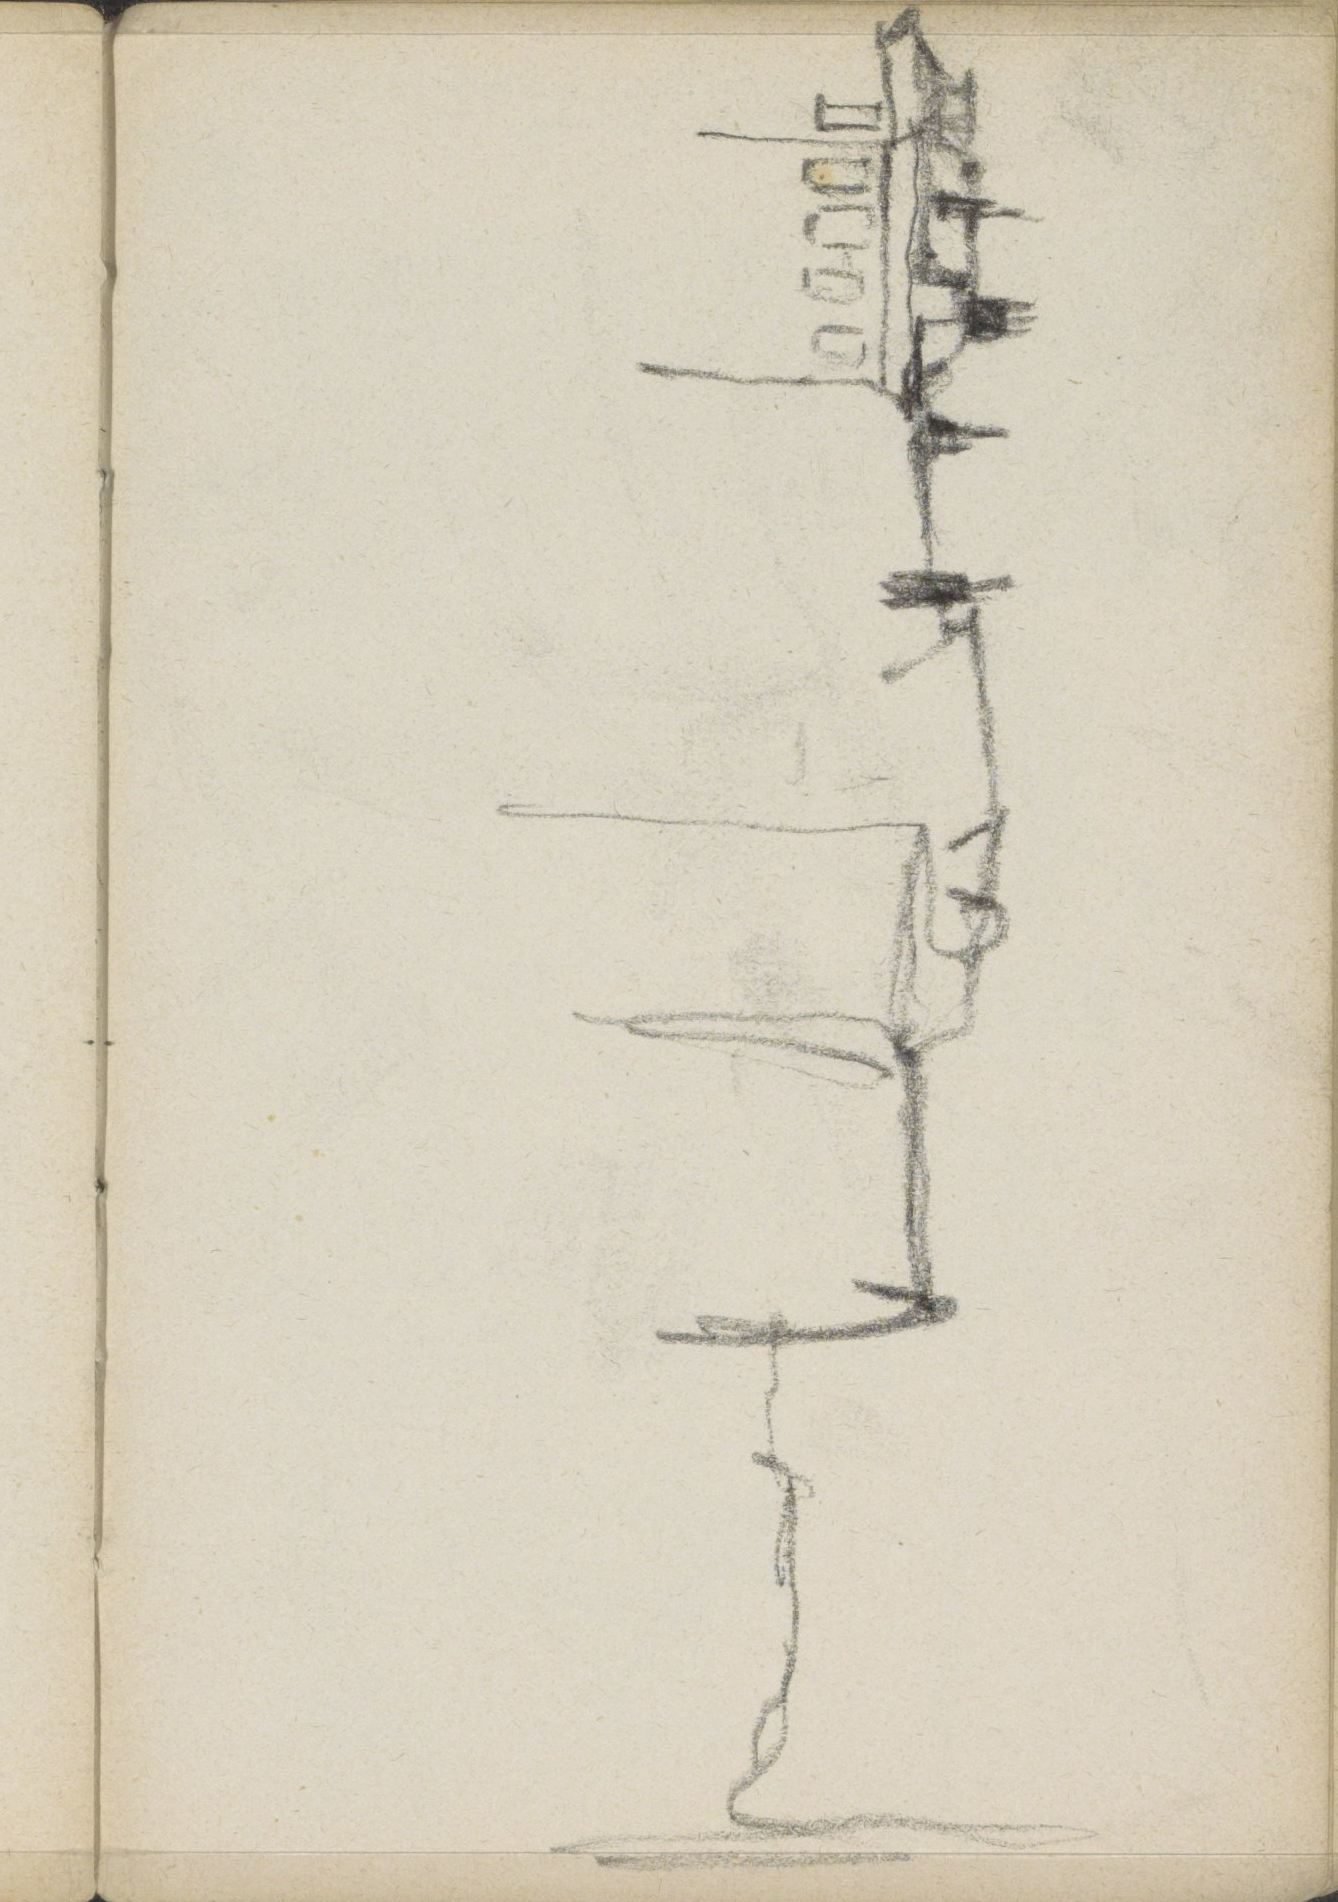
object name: sketchbook leaf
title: Gezicht op gevels, mogelijk aan het Damrak te Amsterdam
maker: george hendrik breitner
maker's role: draughtsman, painter, print maker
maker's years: 1857-1923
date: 1900-1901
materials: chalk, paper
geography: amsterdam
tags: façade (of house or building)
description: Gezicht op gevels, mogelijk aan het Damrak te Amsterdam. Pagina 68 uit een schetsboek met 46 bladen vervaardigd te Amsterdam.